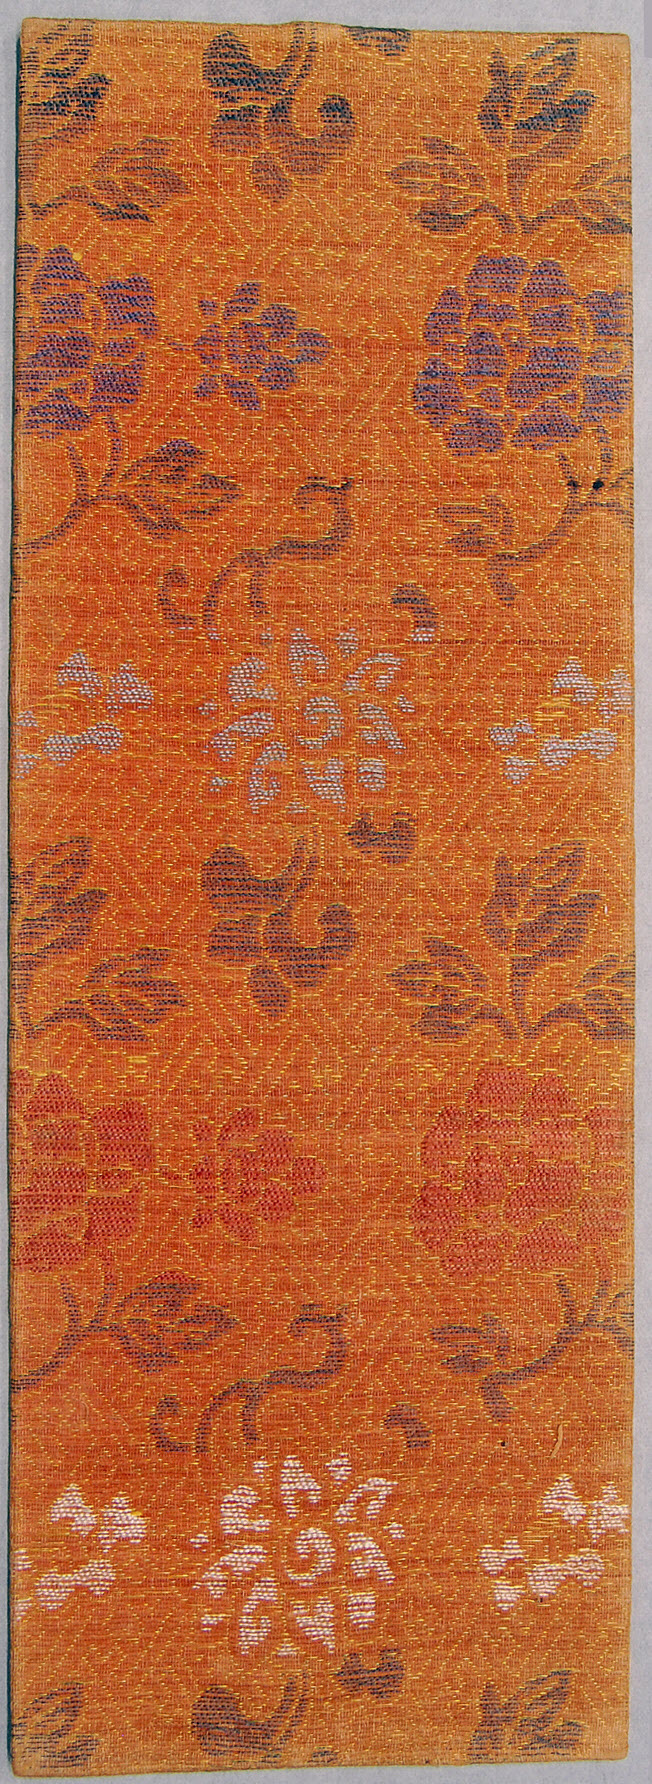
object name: sutra cover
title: Sutra Cover with Alternating Rows of Peonies and Lotus-like Flowers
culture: chinese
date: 1501-1600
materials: silk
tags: peonies,leaves